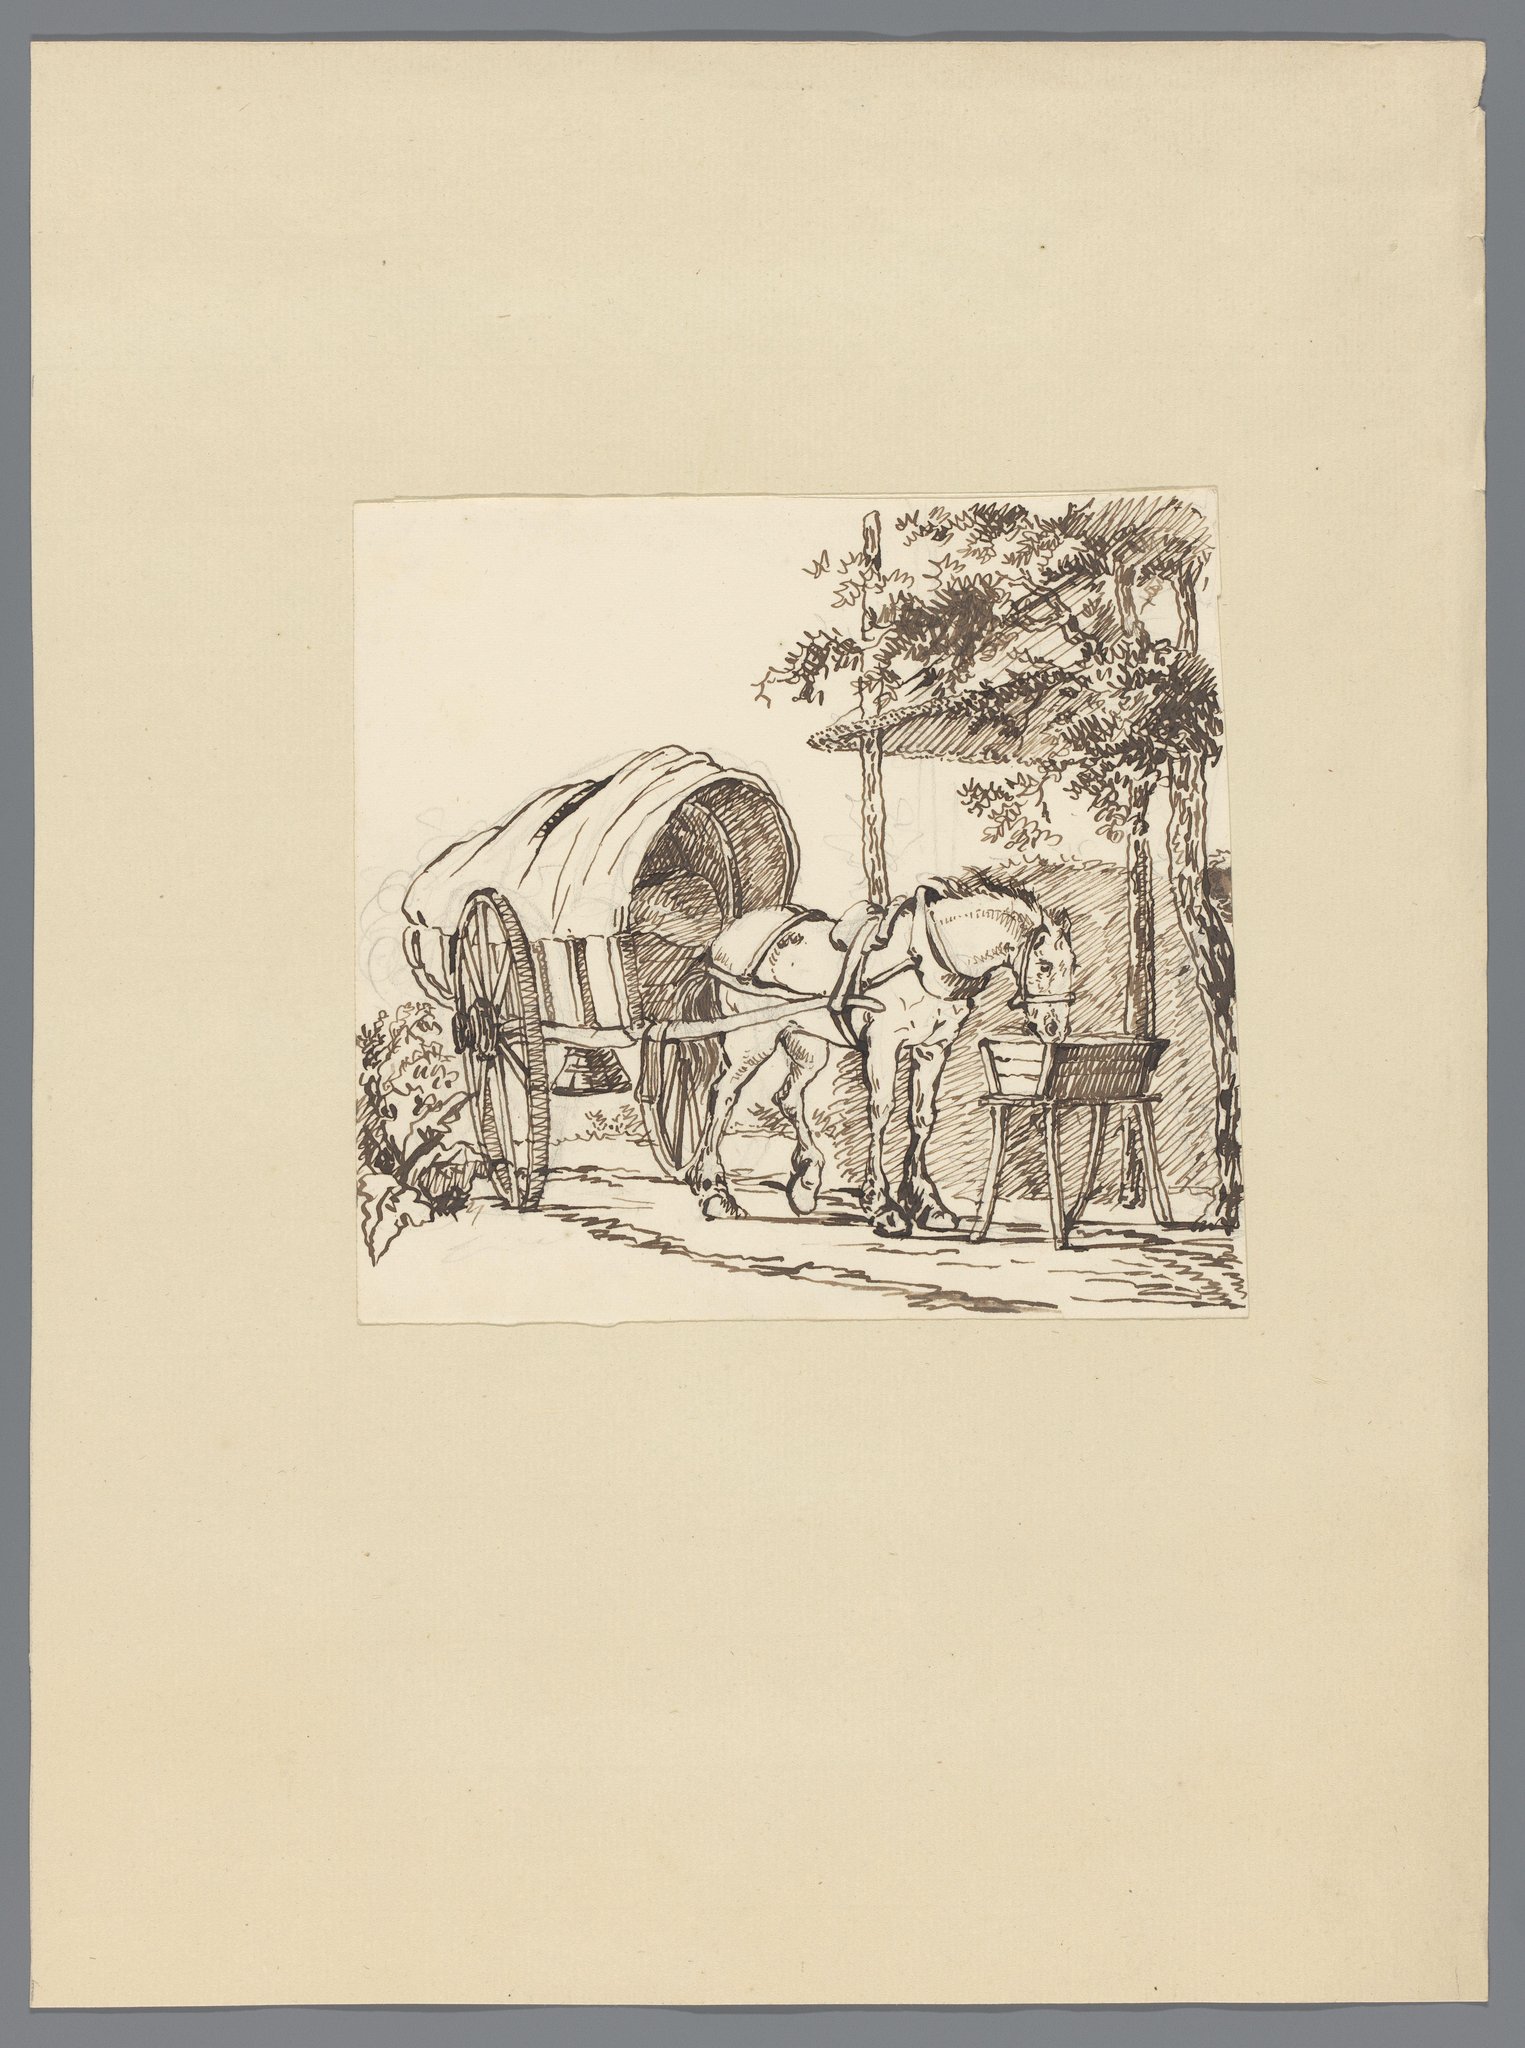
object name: drawing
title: Paard met huifkar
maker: david pièrre giottino humbert de superville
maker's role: draughtsman, painter, print maker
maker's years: 1770-1849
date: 1780-1849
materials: ink, paper, pencil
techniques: pen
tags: (farm) wagon, freight wagon, cart